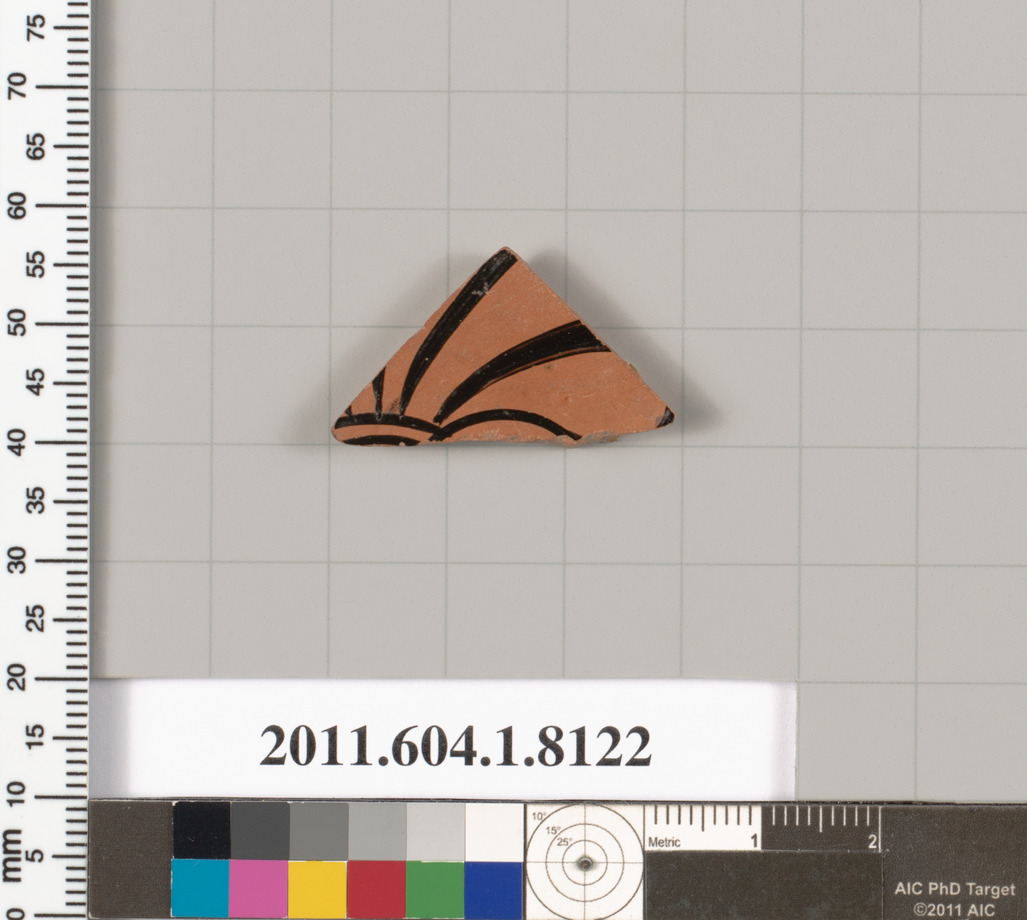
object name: kylix fragment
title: Terracotta fragment of a kylix (drinking cup)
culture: greek, attic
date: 534-468 BCE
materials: terracotta